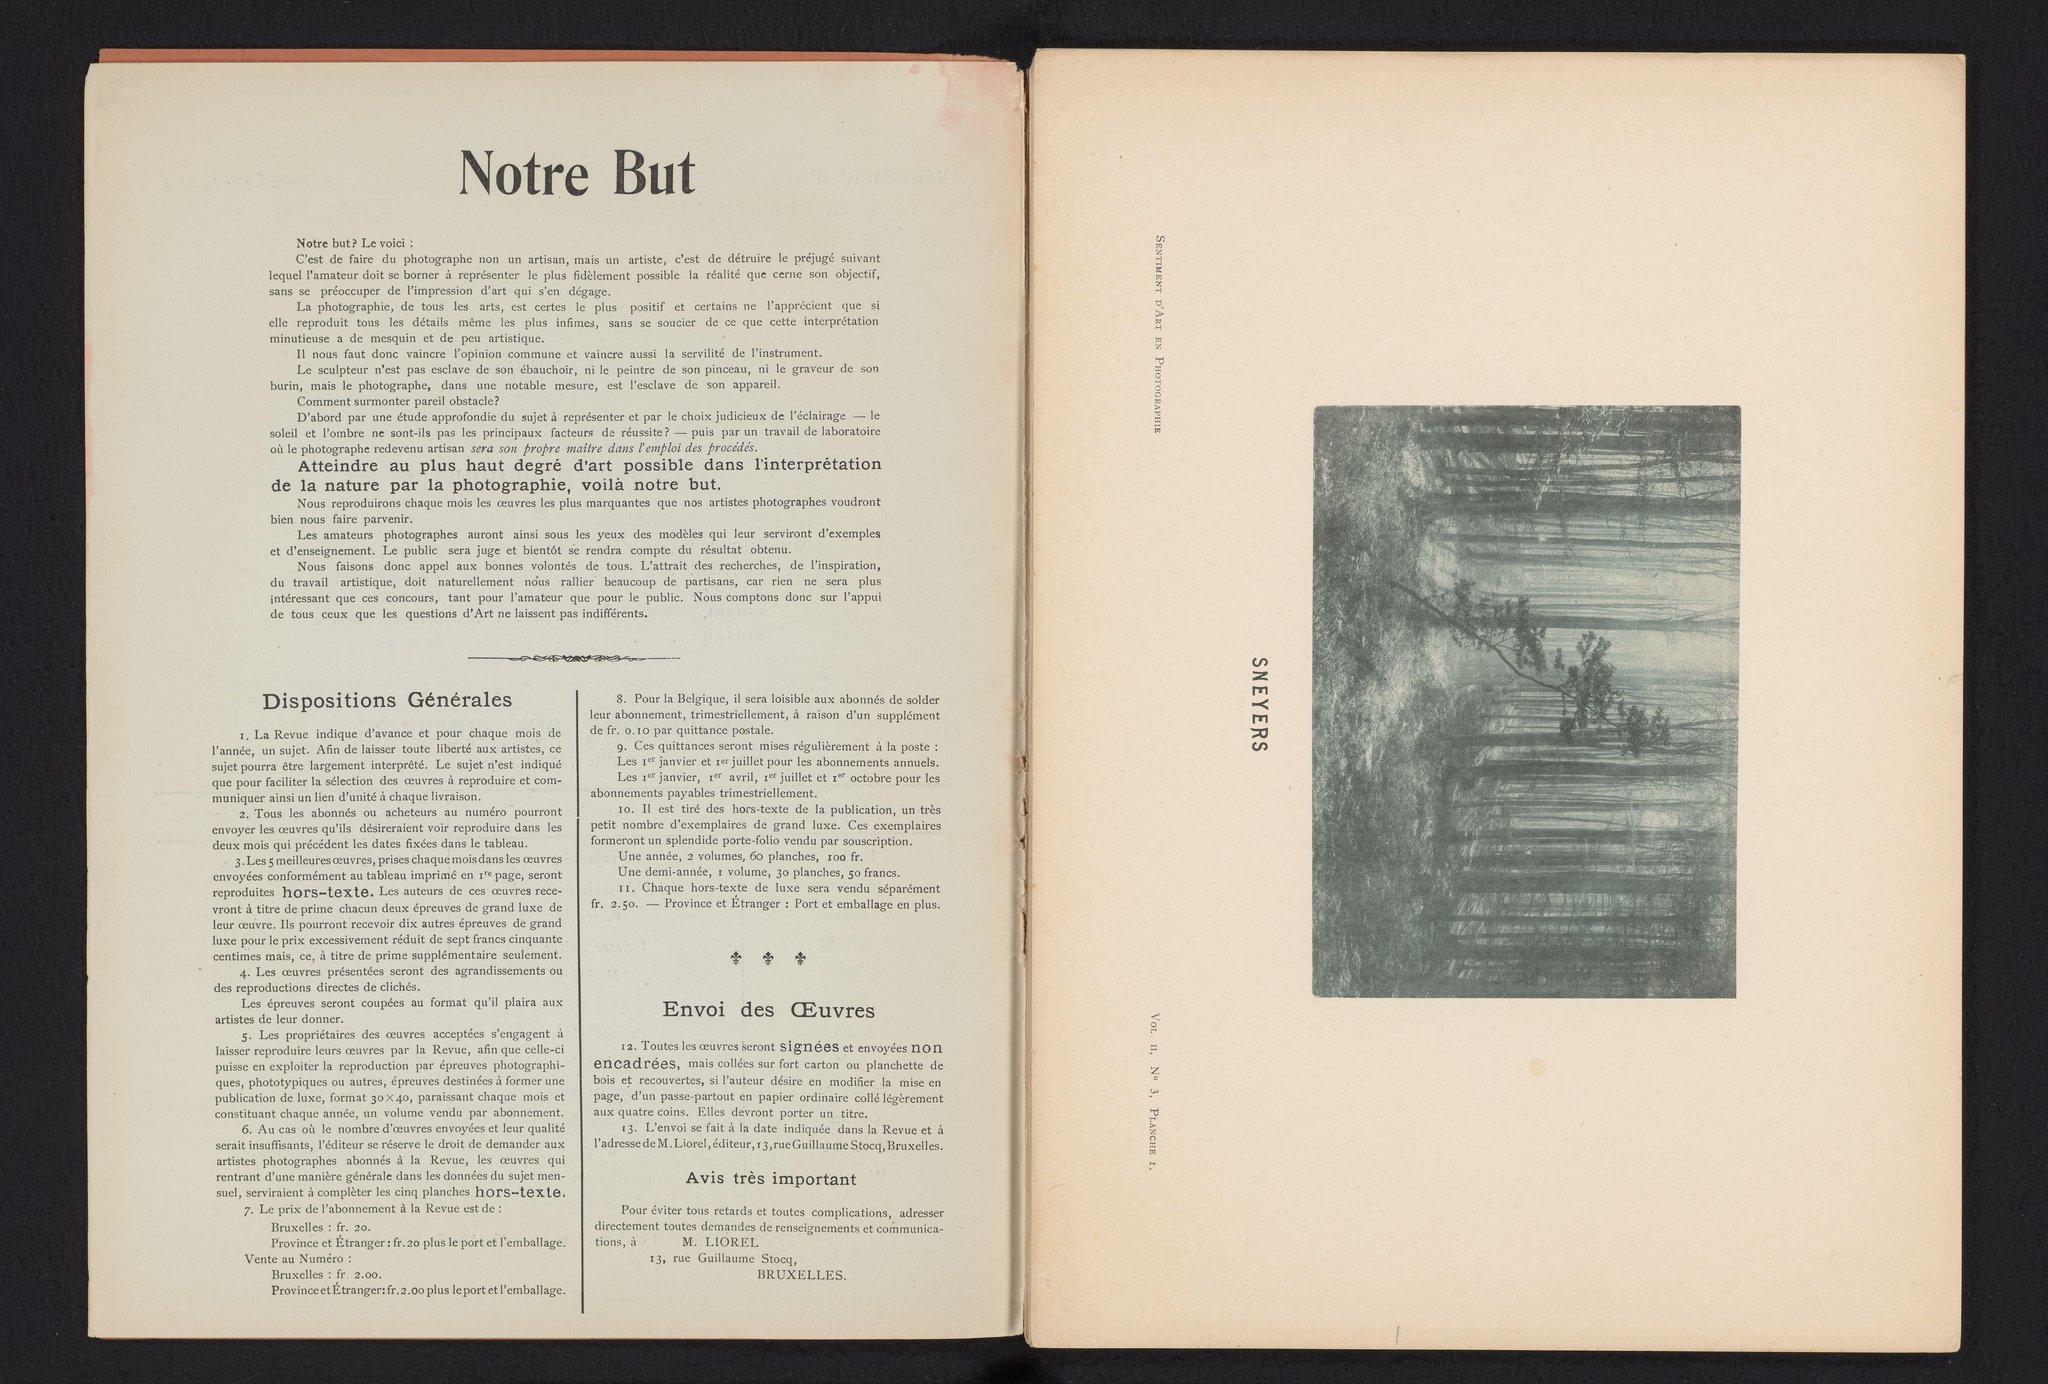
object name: photomechanical print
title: Bos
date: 1895-1900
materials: paper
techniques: photograph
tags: forest, wood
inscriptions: number: ‘Vol. II, No 3, Planche 1.’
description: Deze prent maakt deel uit van 8 omslagen met 22 tekstbladen en 89 prenten op losse bladen in en tussen de omslagen.